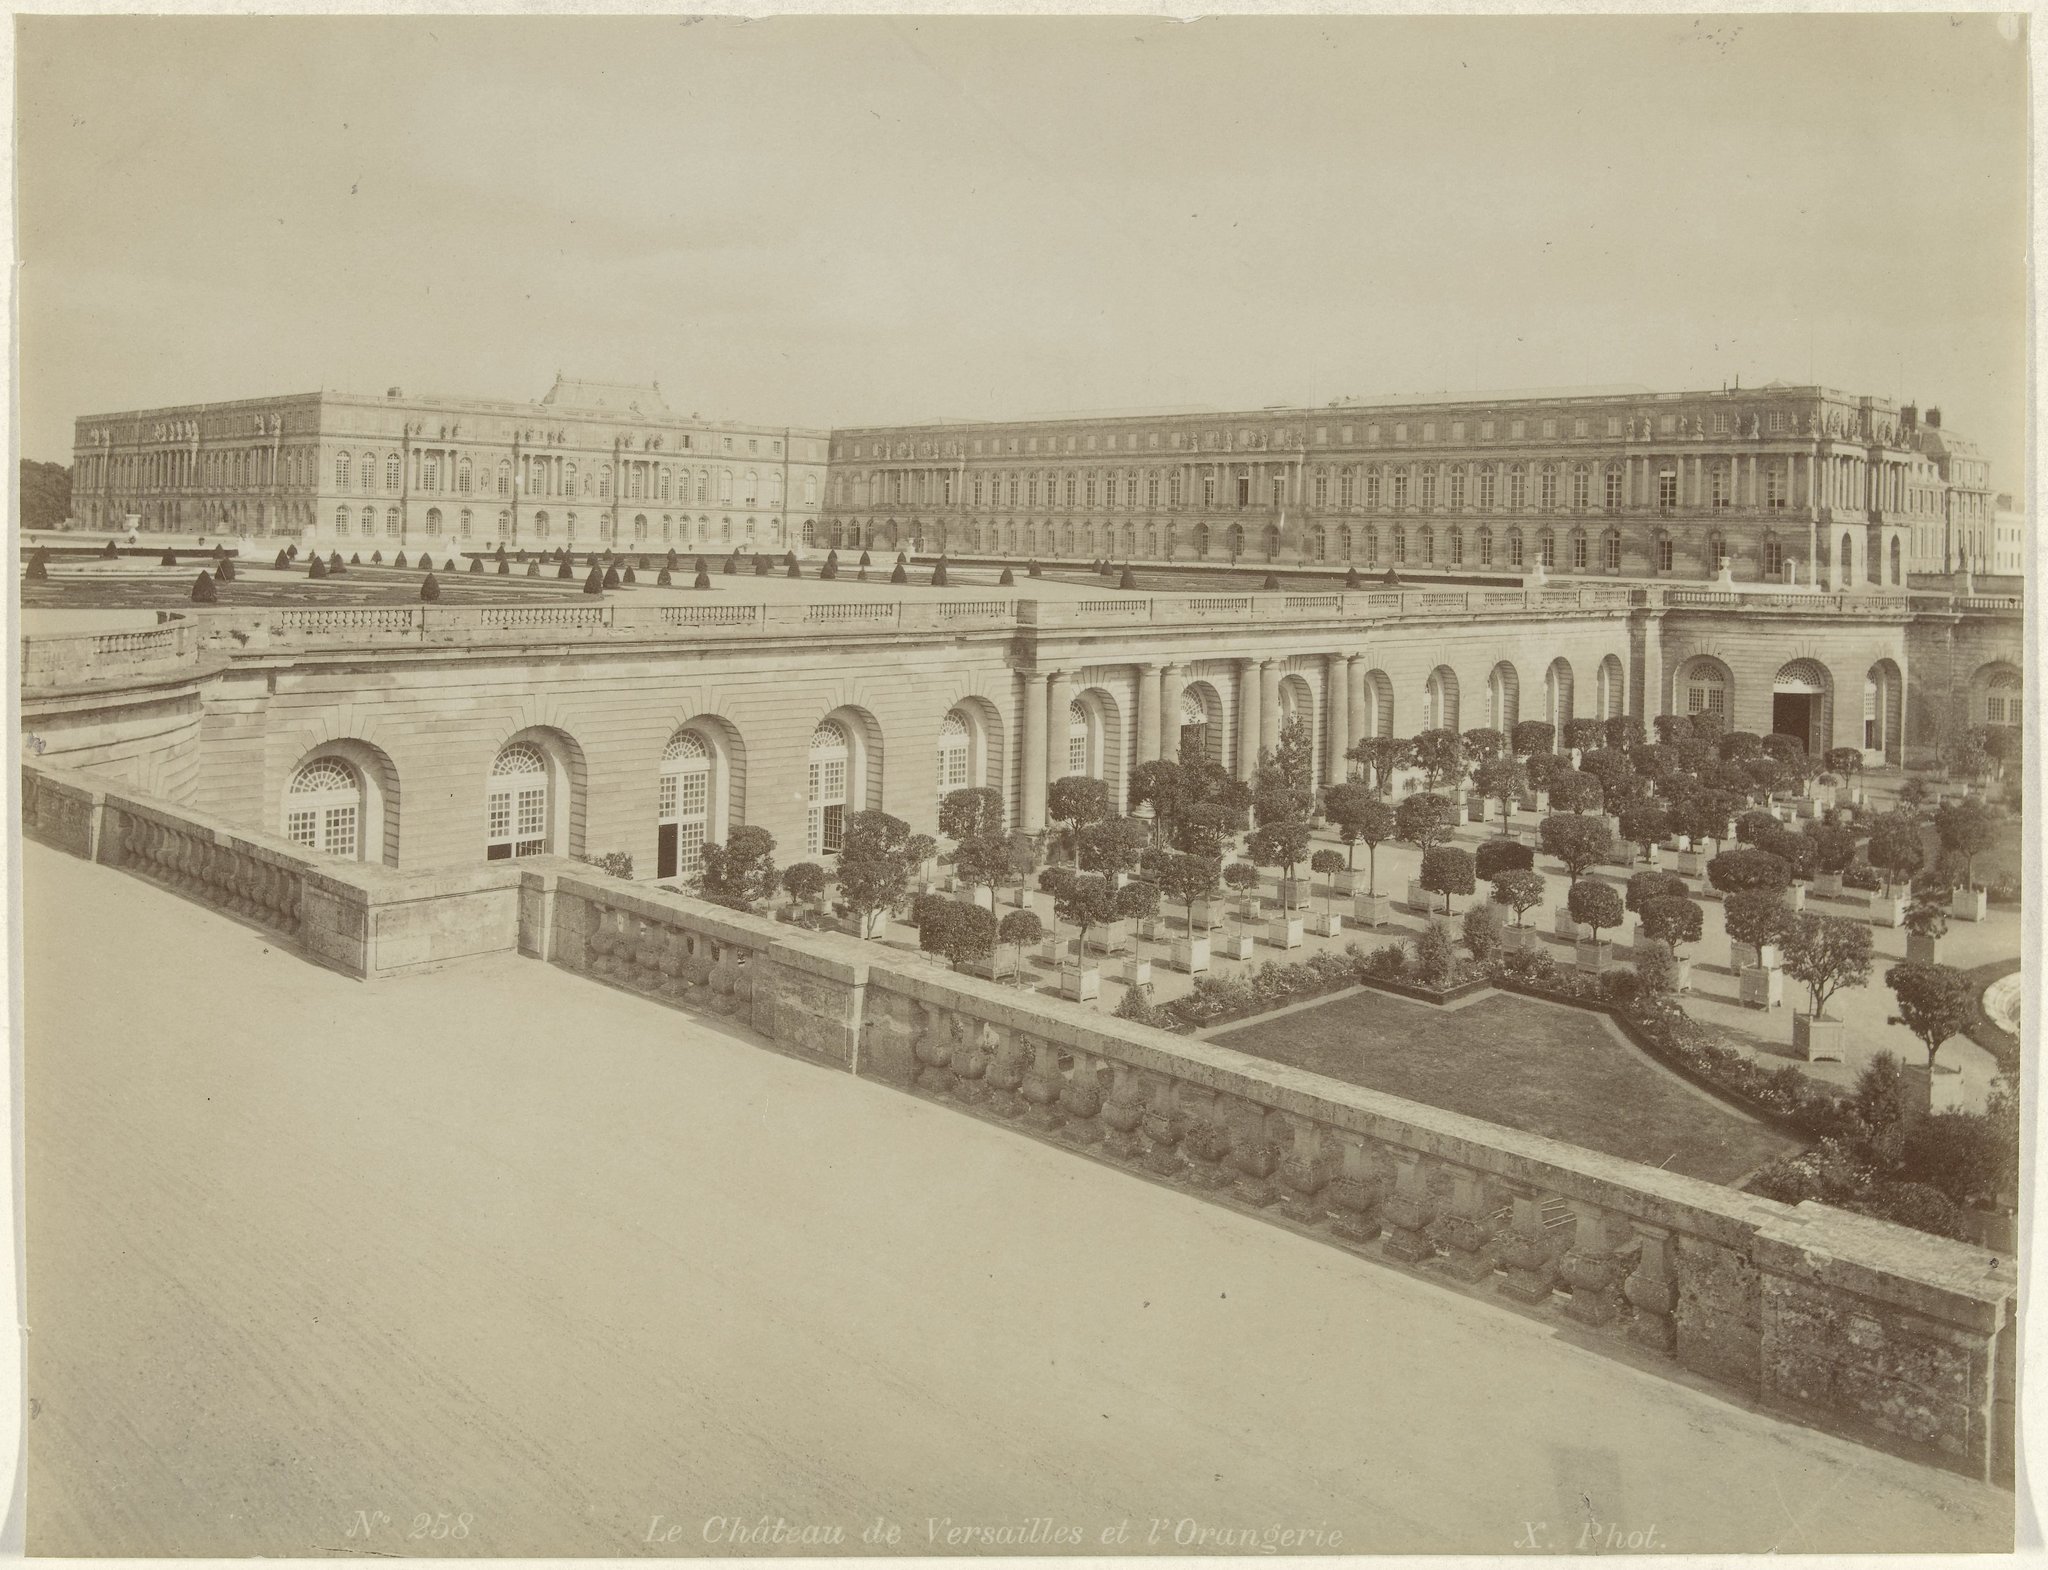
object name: photograph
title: Le Château de Versailles et l'Orangerie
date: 1887-1900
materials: paper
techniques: albumen print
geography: versailles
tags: winter-garden, conservatory, palace, greenhouse, orangery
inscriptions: number: ‘14’, inscription: ‘No 258 Le Château de Versailles et l'Orangerie. X. Phot.’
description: Tussen 1887 en ca. 1900 werkten Neurdein frères onder andere onder de naam 'X phot.'.